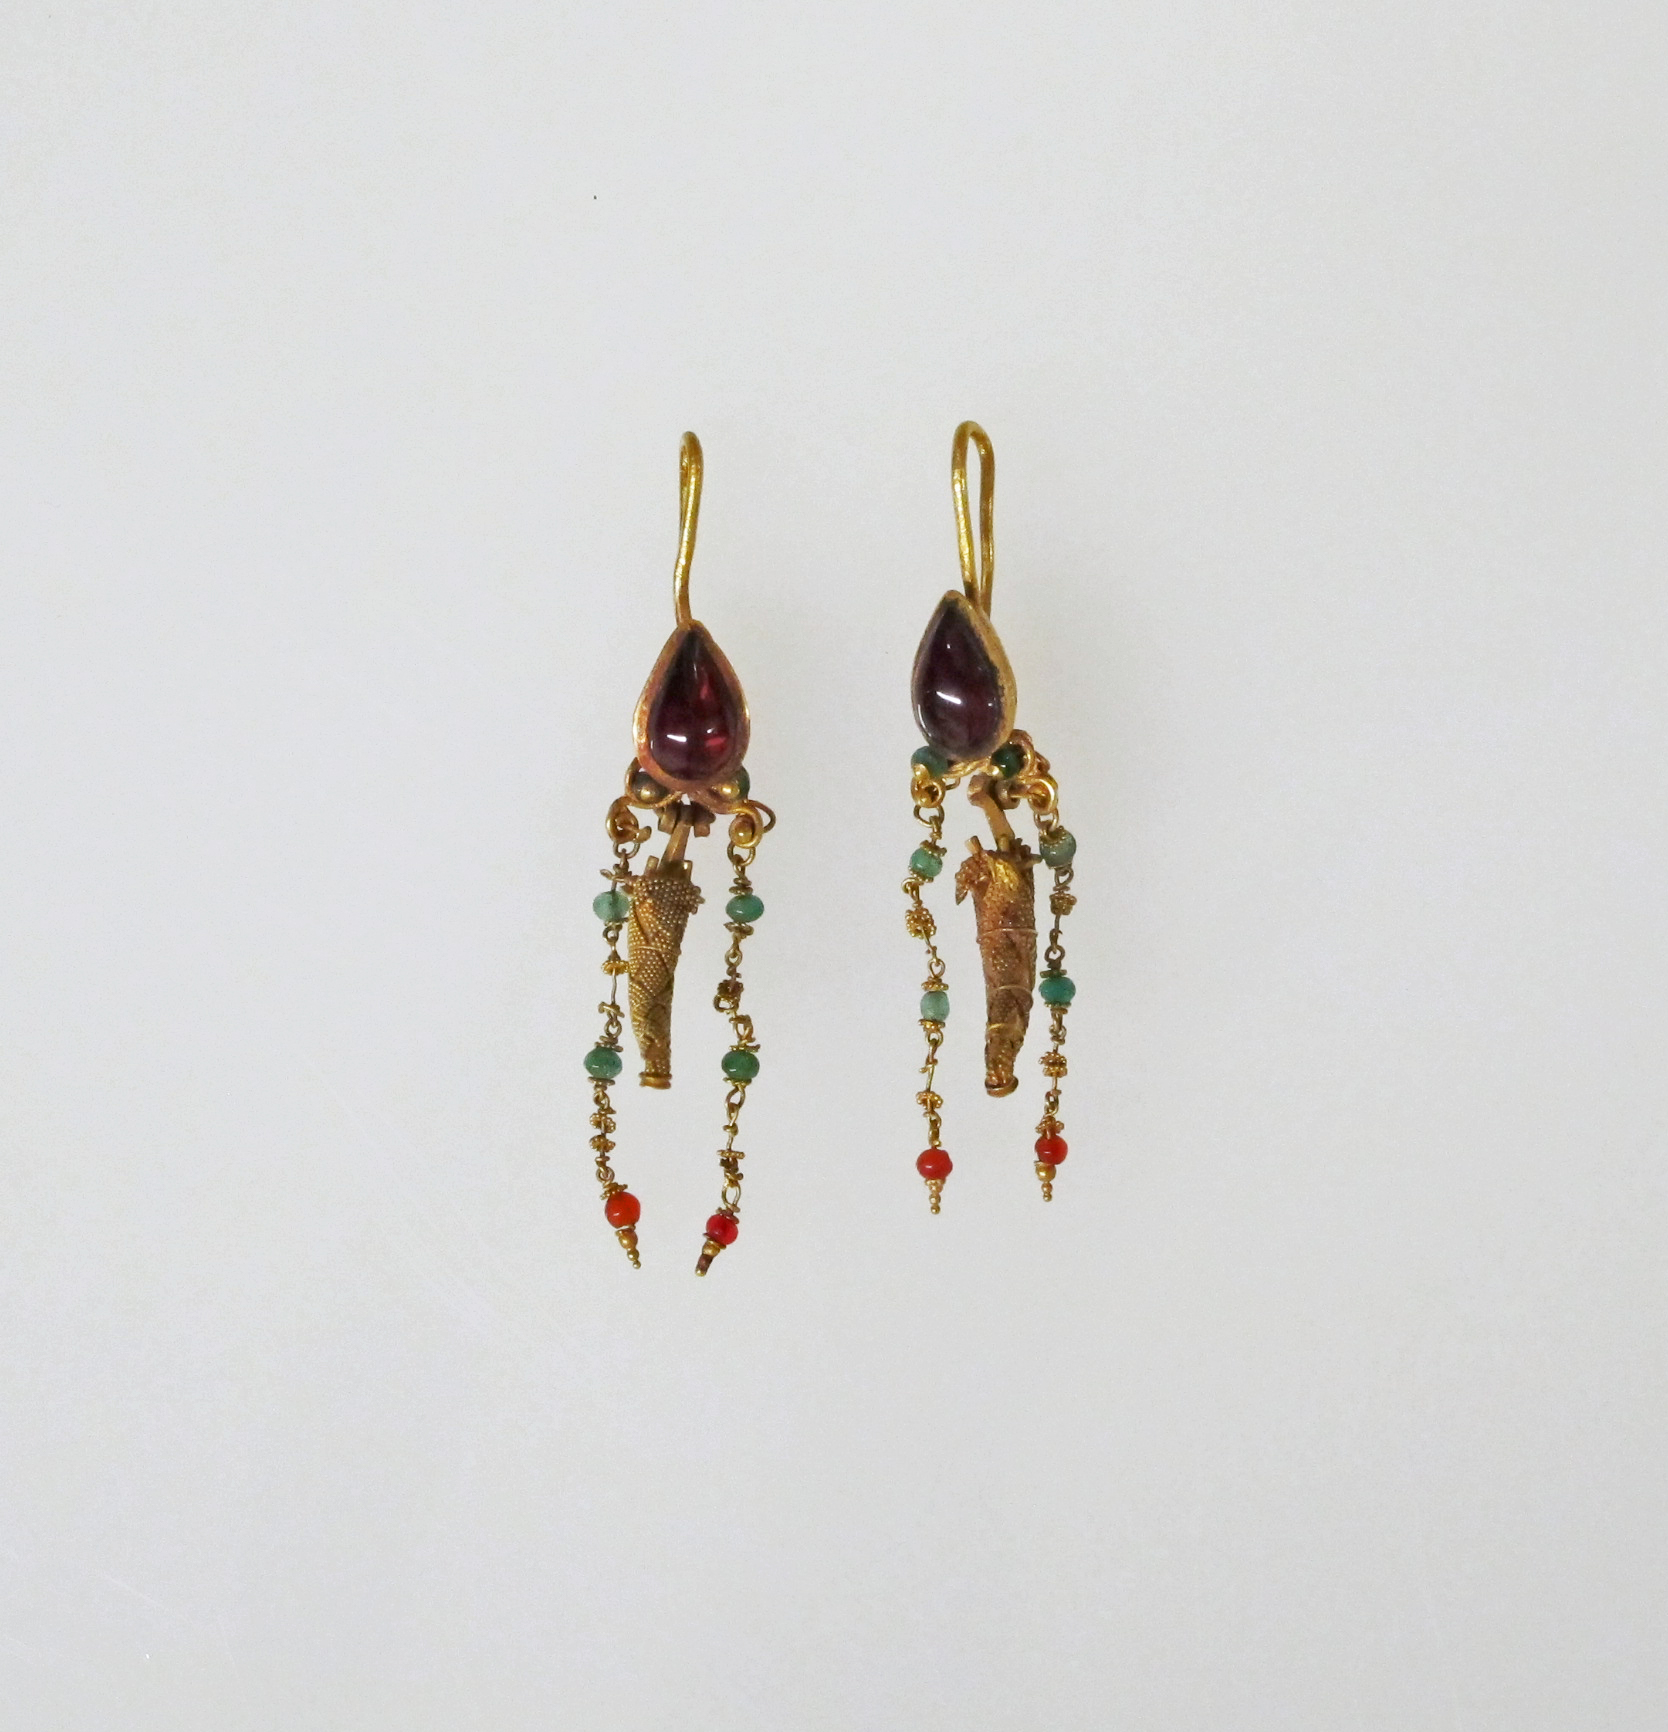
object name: earring with pendant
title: Earring with pendant and chains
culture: roman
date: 101-300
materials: gemstone, gold